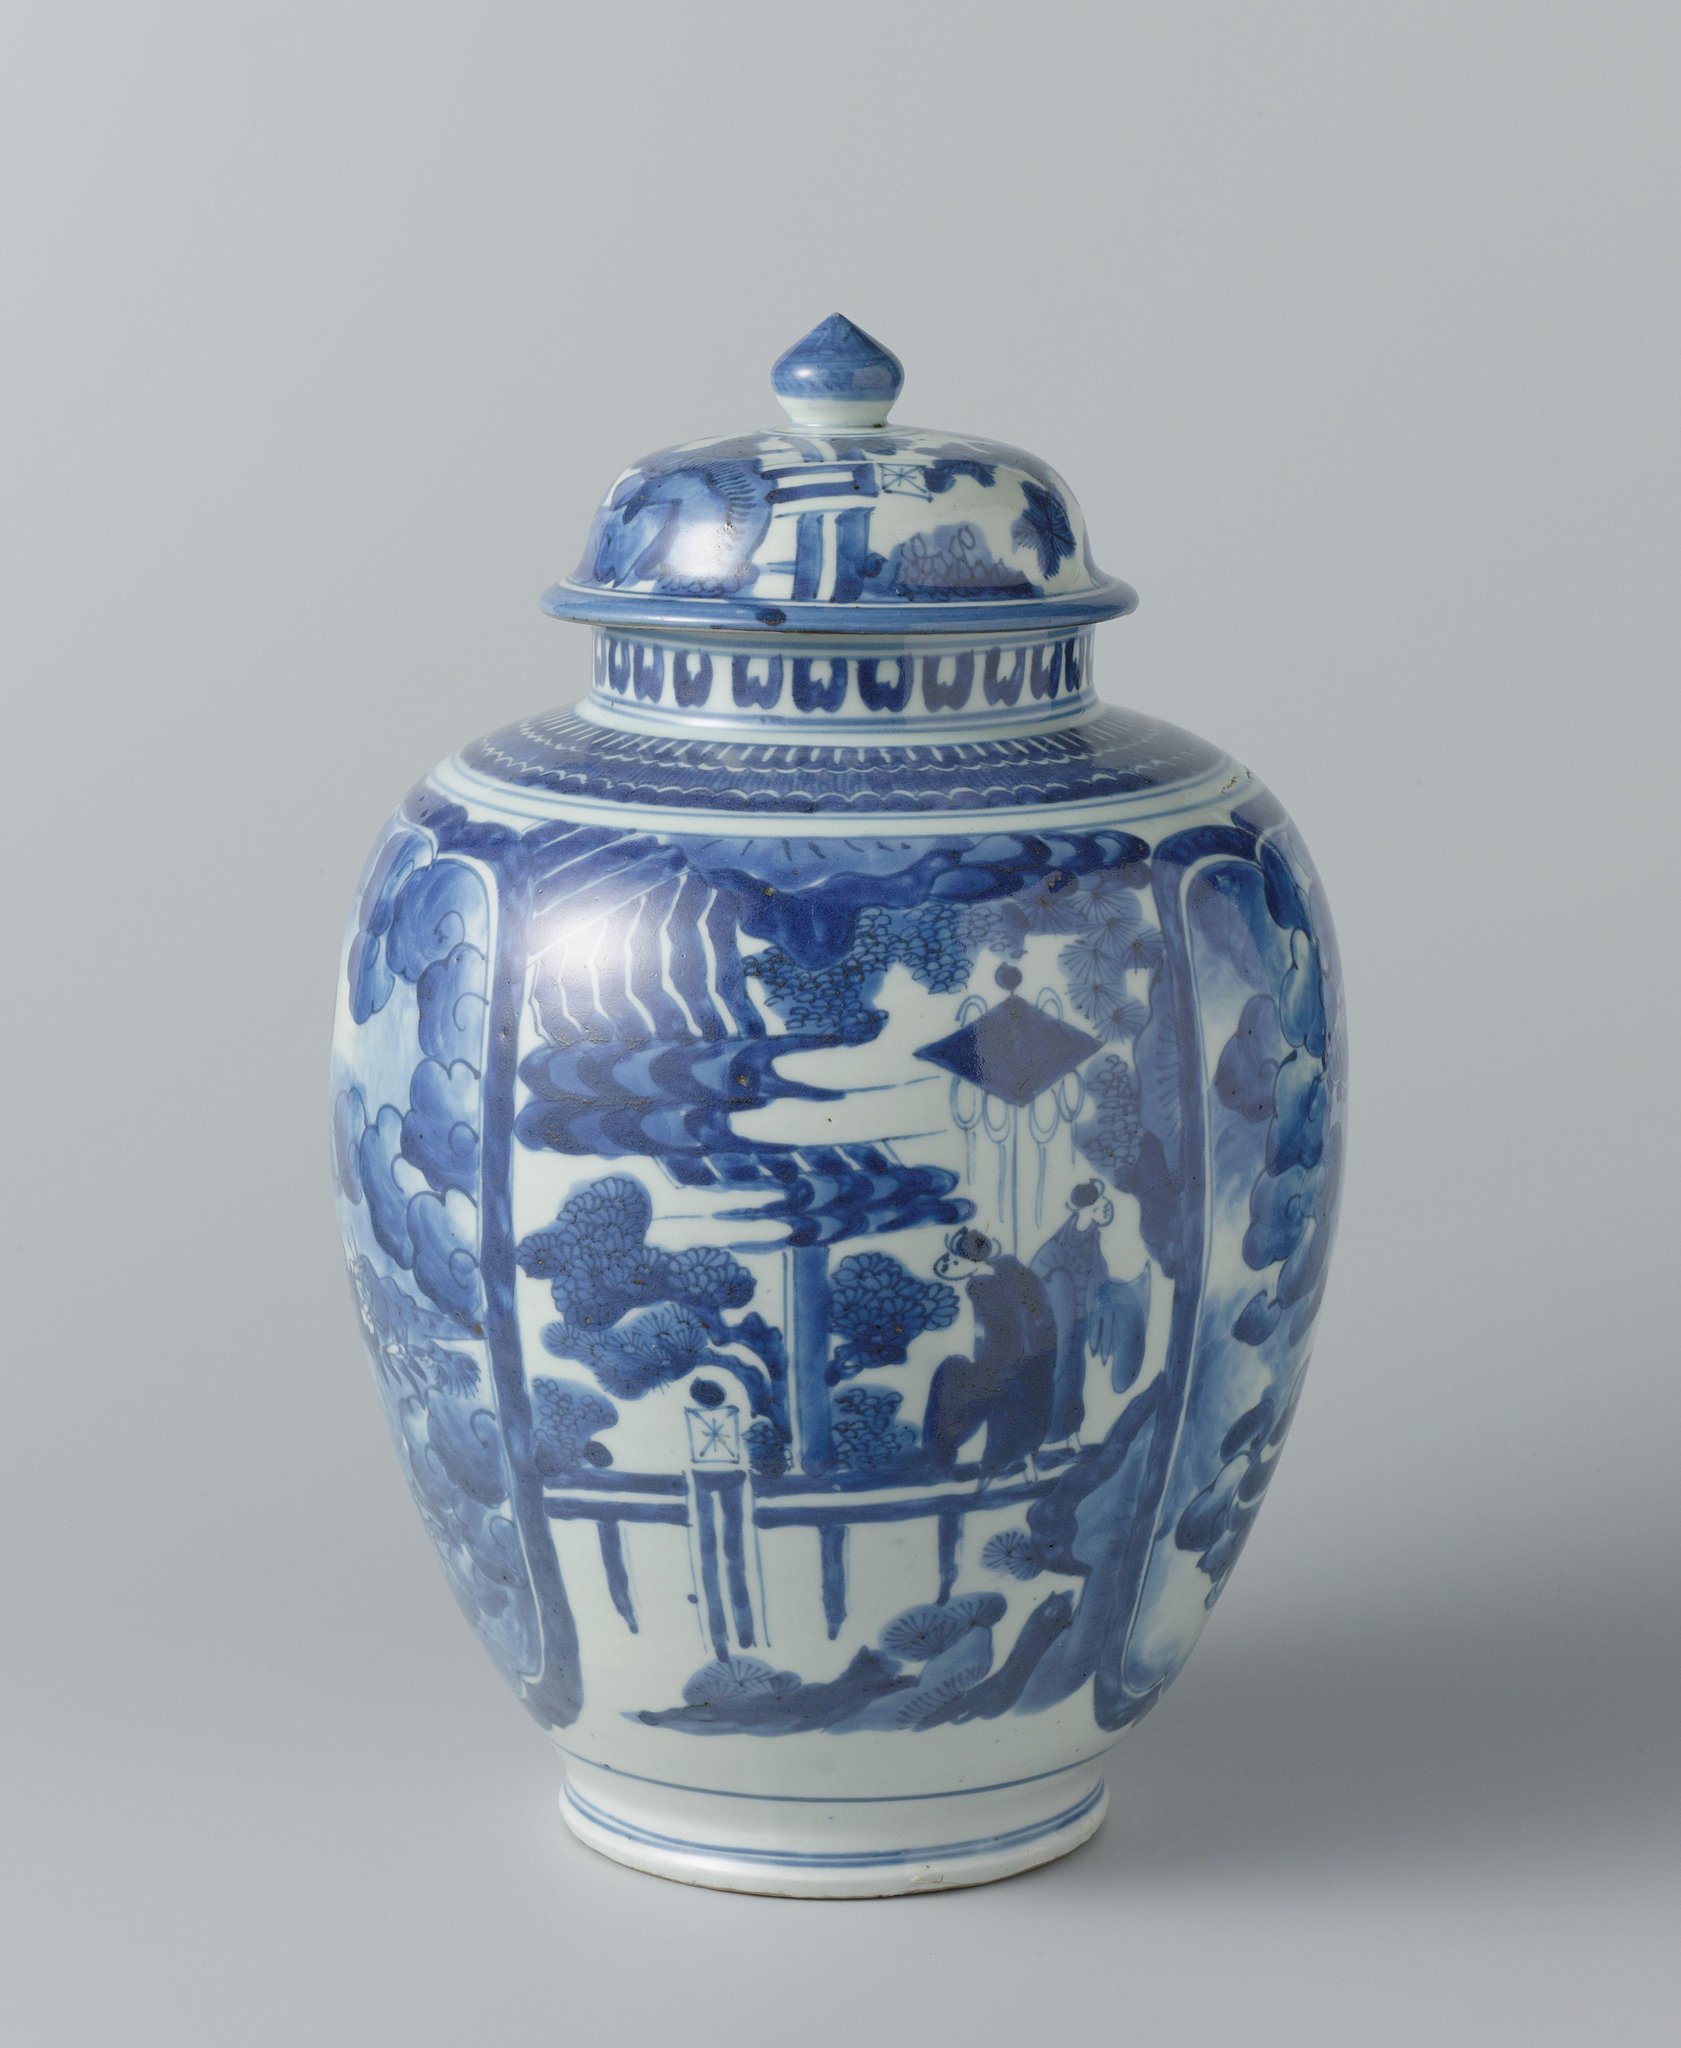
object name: lid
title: Ovoid covered jar with figures in a landscape and panels with dragons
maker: Anonymous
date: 1670-1680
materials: cobalt, glaze, paint, porcelain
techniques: firing, turning, vitrification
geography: arita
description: Ei-vormige dekselpot met een korte, wijde hals en een klokvormige deksel met puntige dekselknop. Beschilderd in onderglazuur blauw met twee grote panelen met draken die in de wolken op een parel jagen. Tussen deze velden aan één zijde een landschap met een pijnboom en een hek, aan de andere zijde twee figuren in een landschap. Op het deksel een landschap.